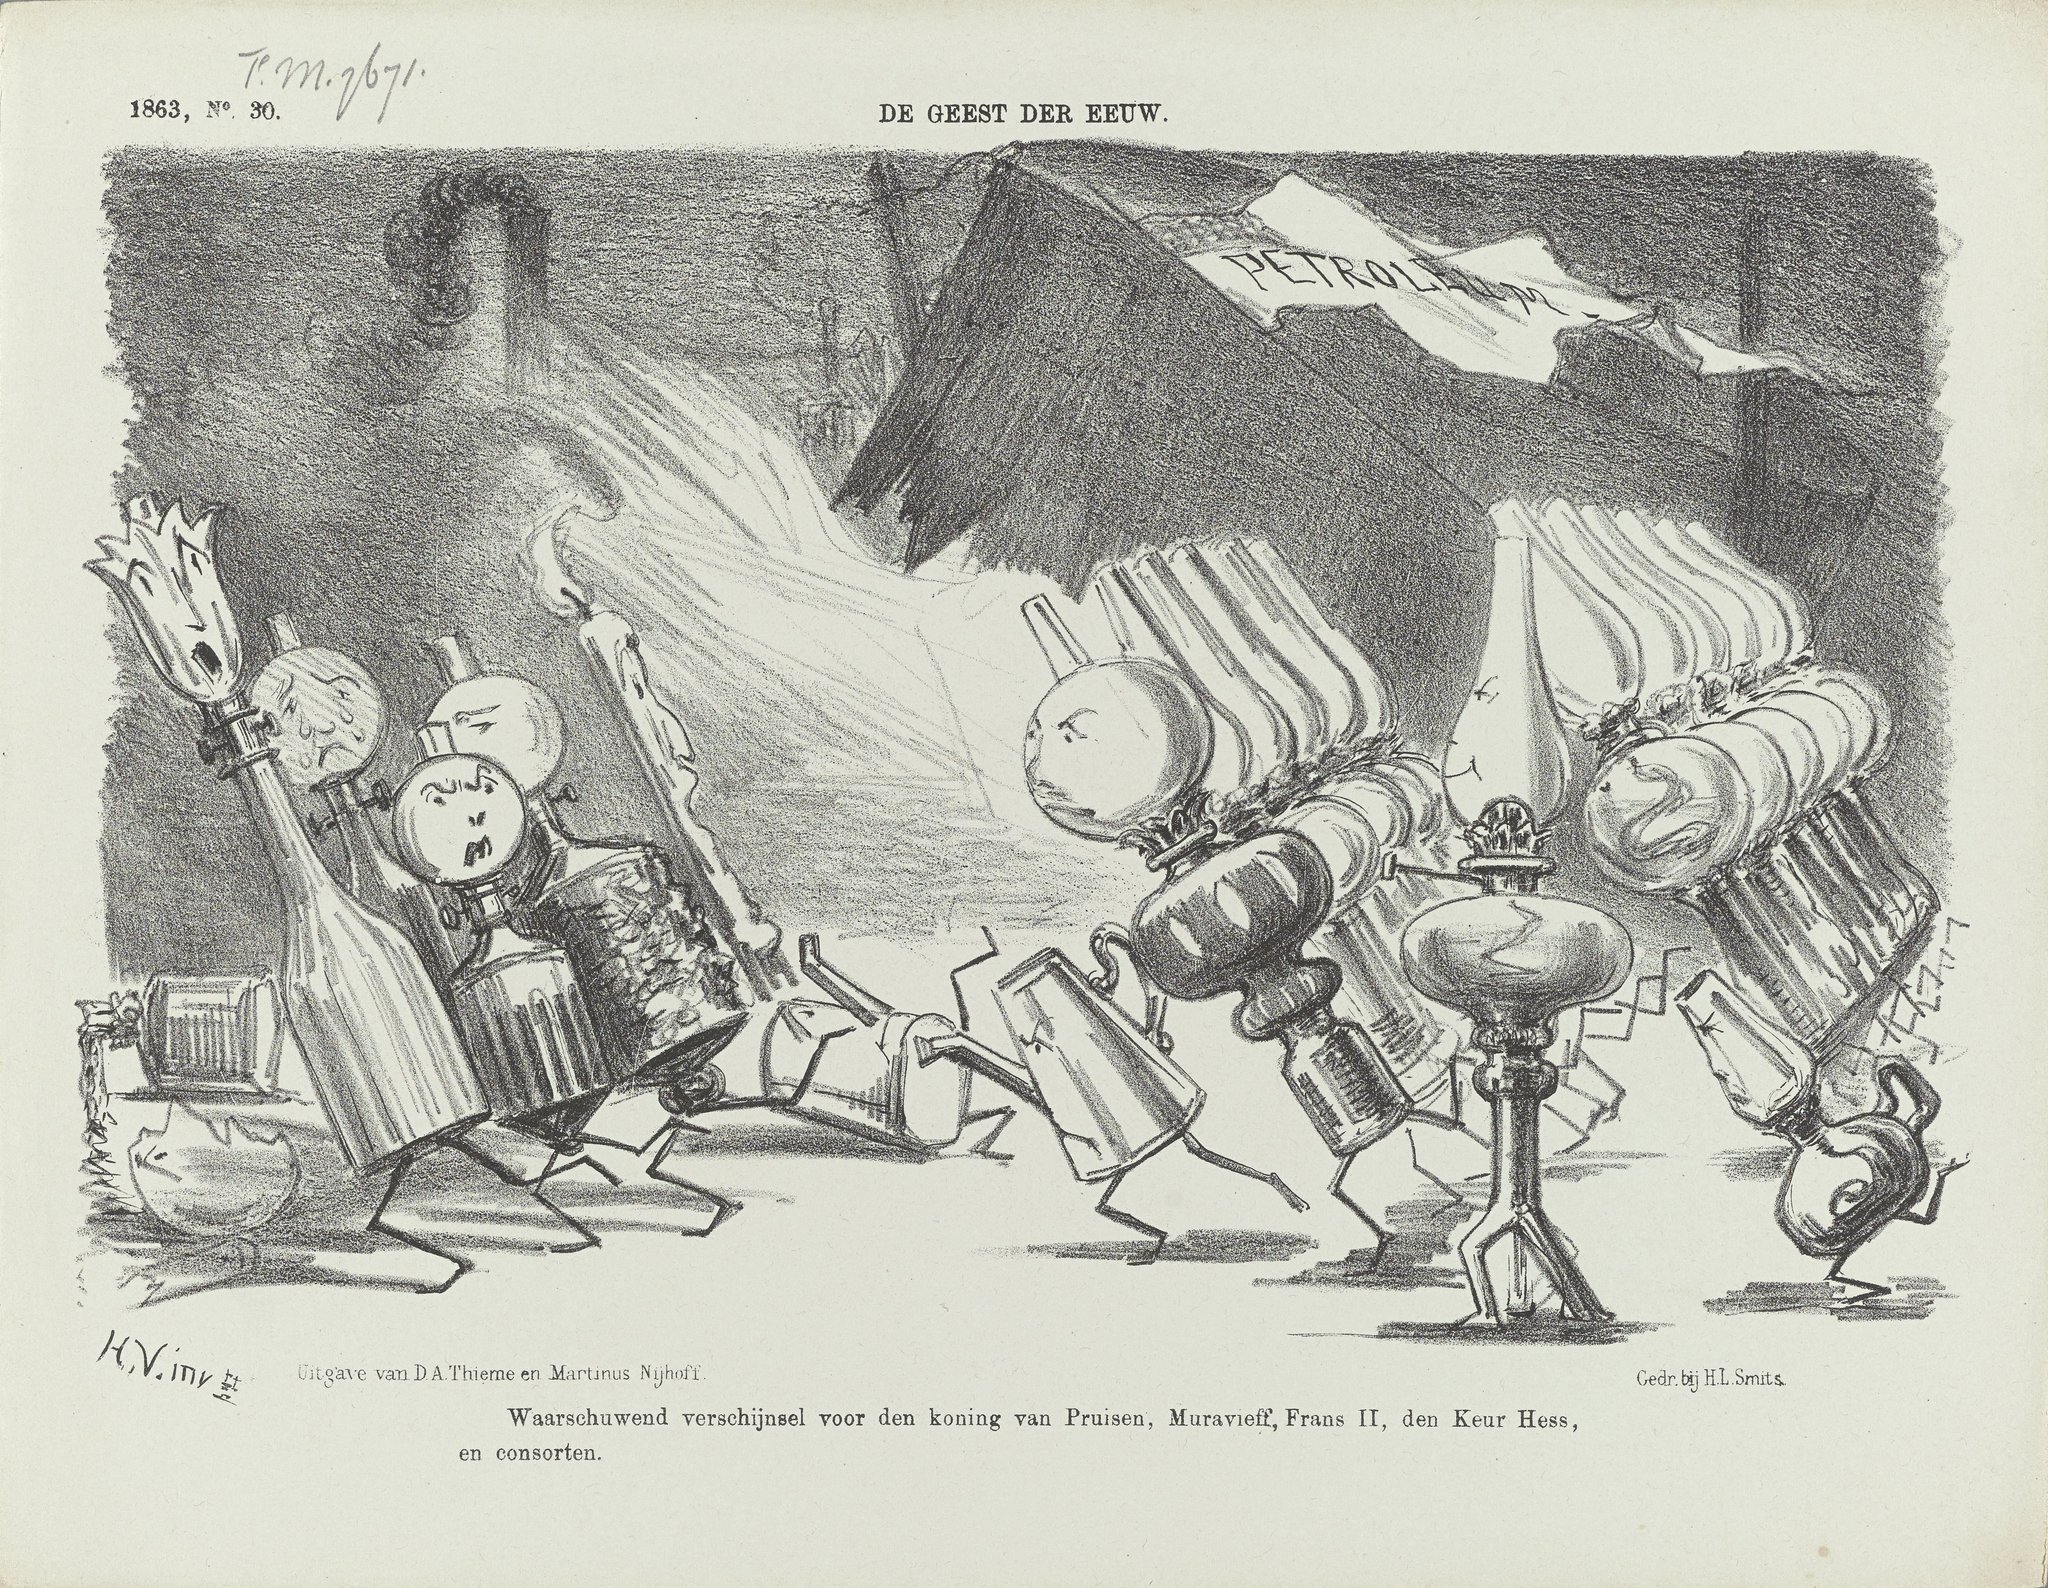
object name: cartoon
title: De geest der eeuw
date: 1863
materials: paper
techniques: lithograph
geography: netherlands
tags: oil-lamp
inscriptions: collector's mark: Lugt 2228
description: Spotprent over de opkomst van de petroleumlamp, ten koste van de kaars en moderateurlampen. Plaat verschenen bij het weekblad De Nederlandsche Spectator, nr. 30, 25 juli 1863.